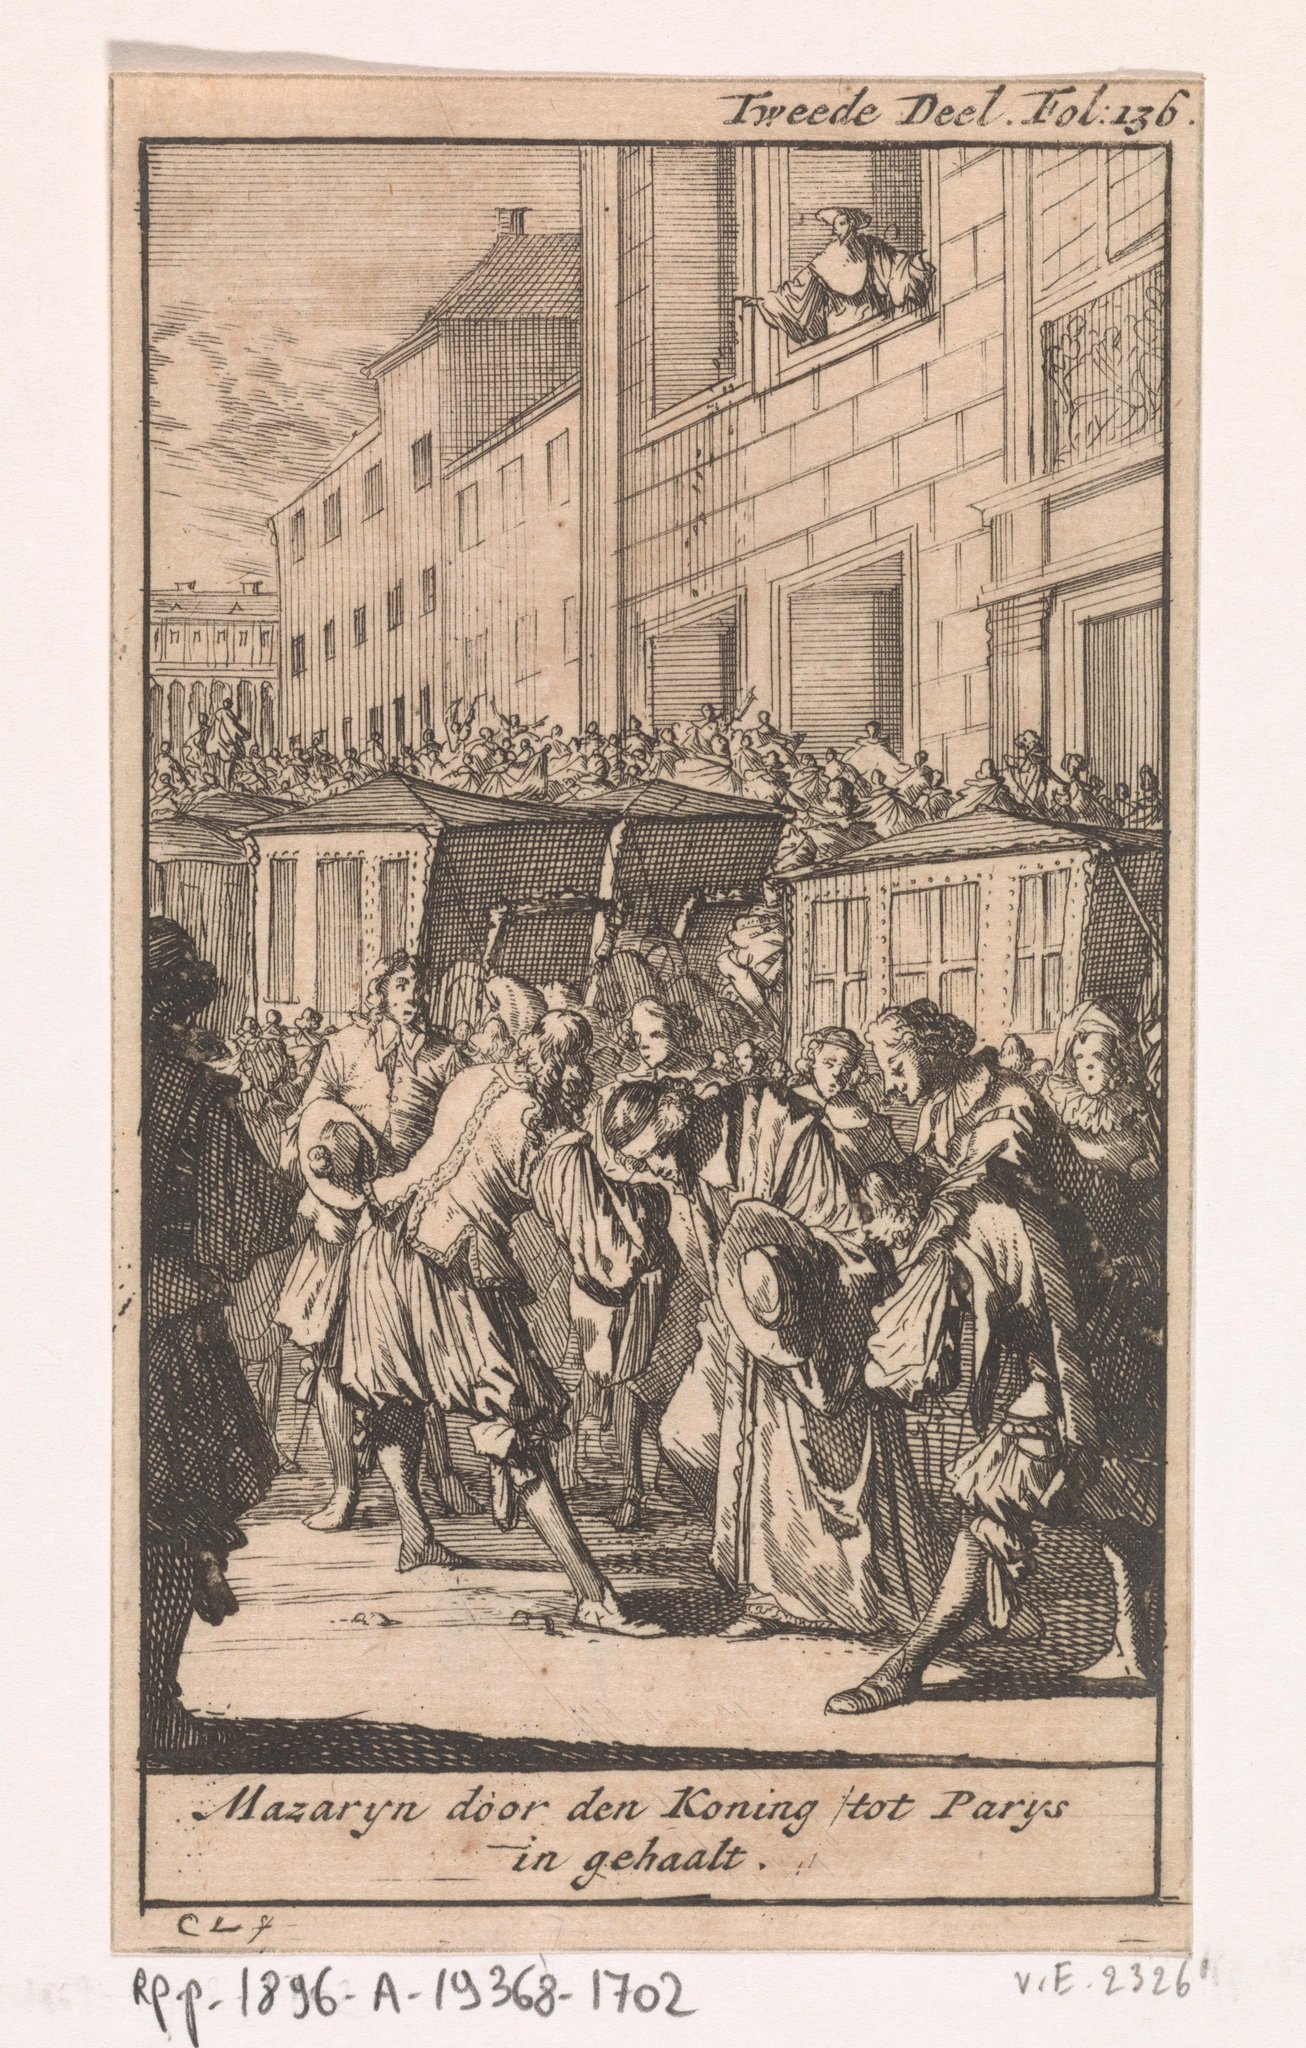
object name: book illustration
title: Mazaryn door den Koning tot Parys in gehaalt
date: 1699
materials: paper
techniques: etching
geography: leiden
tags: lodewijk xiv (koning van frankrijk), jules mazarin, baring the head, lifting one's hat, paris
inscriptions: collector's mark: Lugt 2228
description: Boekillustratie voor Het leven en bedryf van den wytberoemden en grooten staatkundigen Julius Mazaryn. Leiden: Boudewijn van der Aa, 1699, dl. 2, f. 136.